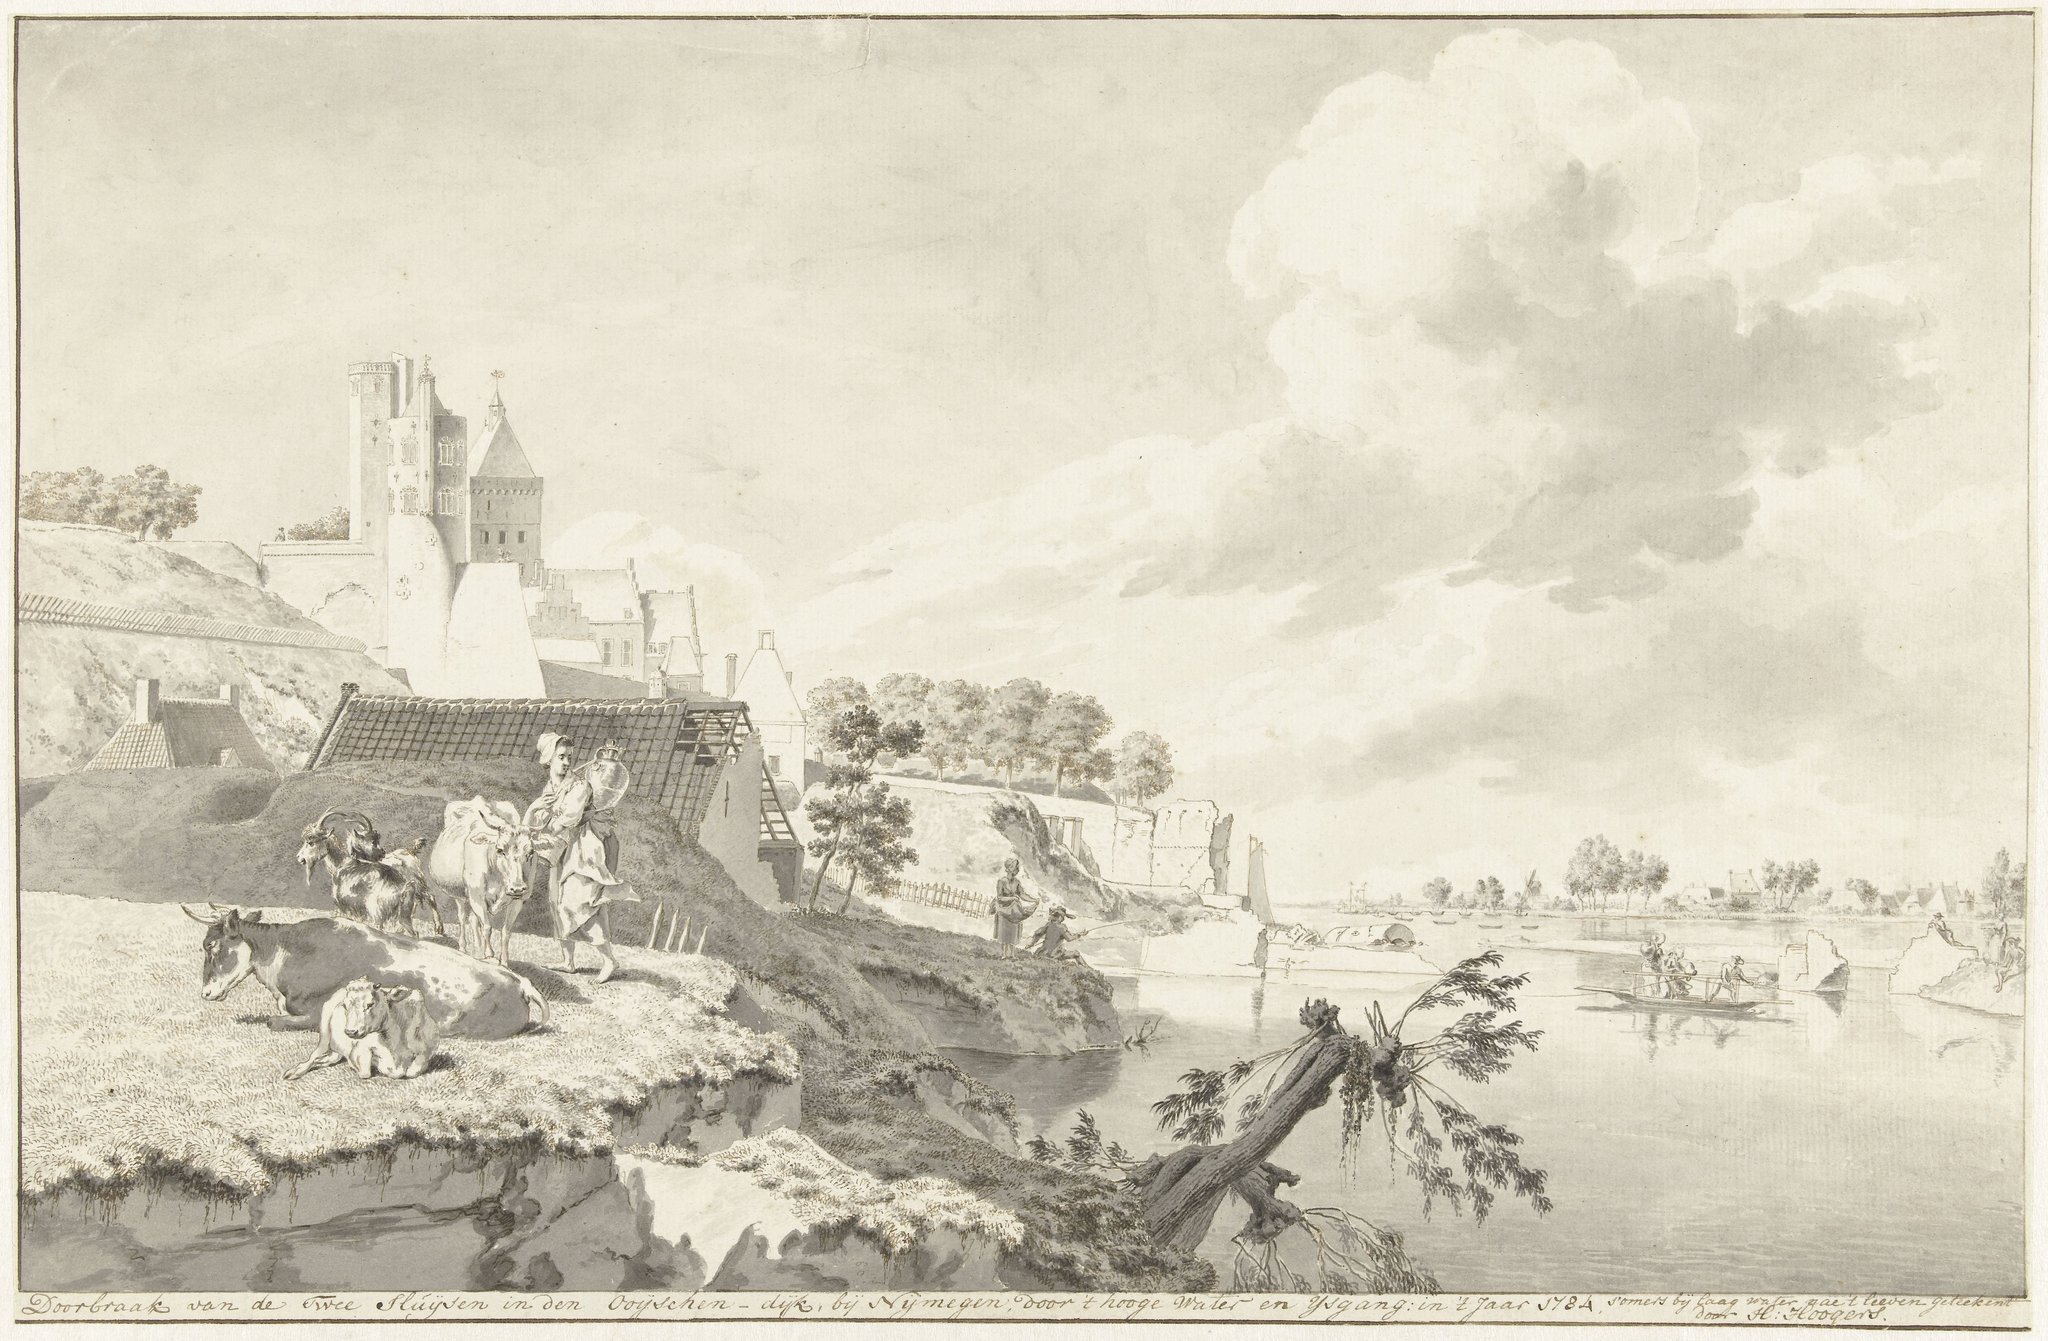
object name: drawing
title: Gezicht op het Valkhof te Nijmegen en de doorgebroken sluizen bij de Ooischendijk, 1784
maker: hendrik hoogers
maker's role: draughtsman, mayor, print maker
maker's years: 1747-1814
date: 1784-1814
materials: ink, paper, pencil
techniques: brush, pen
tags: flood, historical events and situations, nijmegen